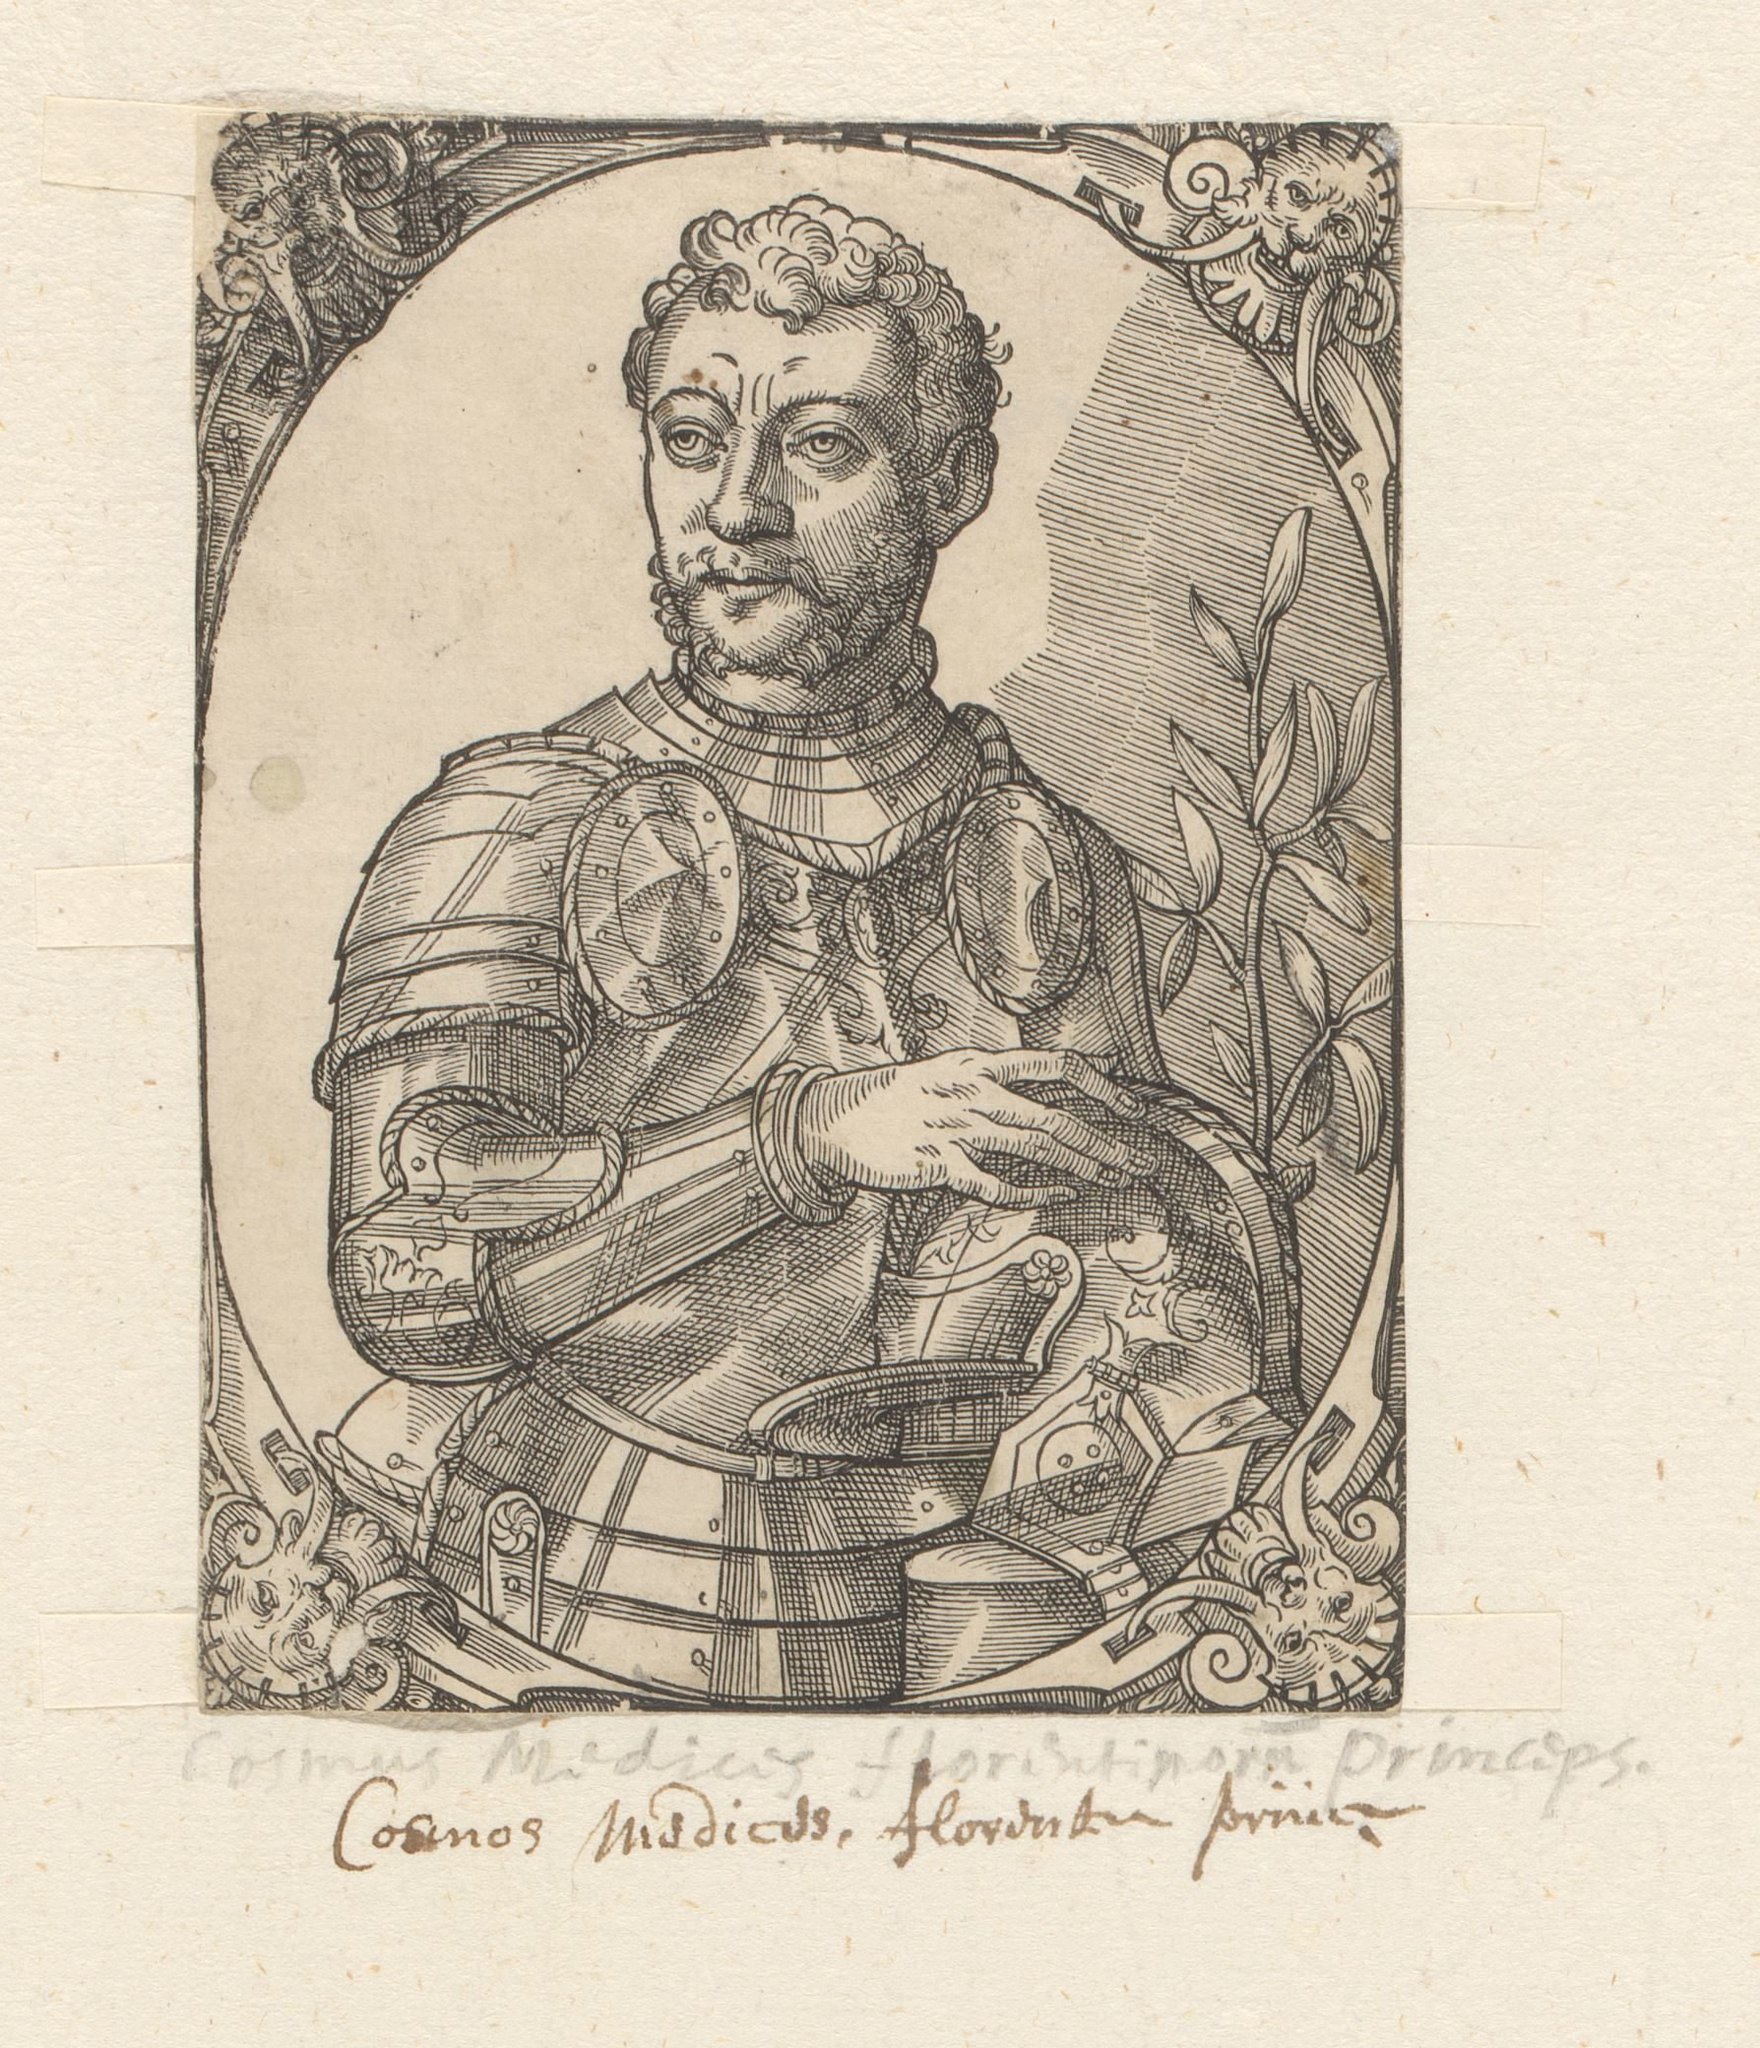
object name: print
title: Portret van Cosimo de' Medici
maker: Anonymous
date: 1549-1577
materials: paper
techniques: woodcut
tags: cosimo i de' medici, historical persons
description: Prent gebruikt in: Giovio, Paolo. Musaei Ioviani Imagines (...). Bazel: Peter Perna, 1577.